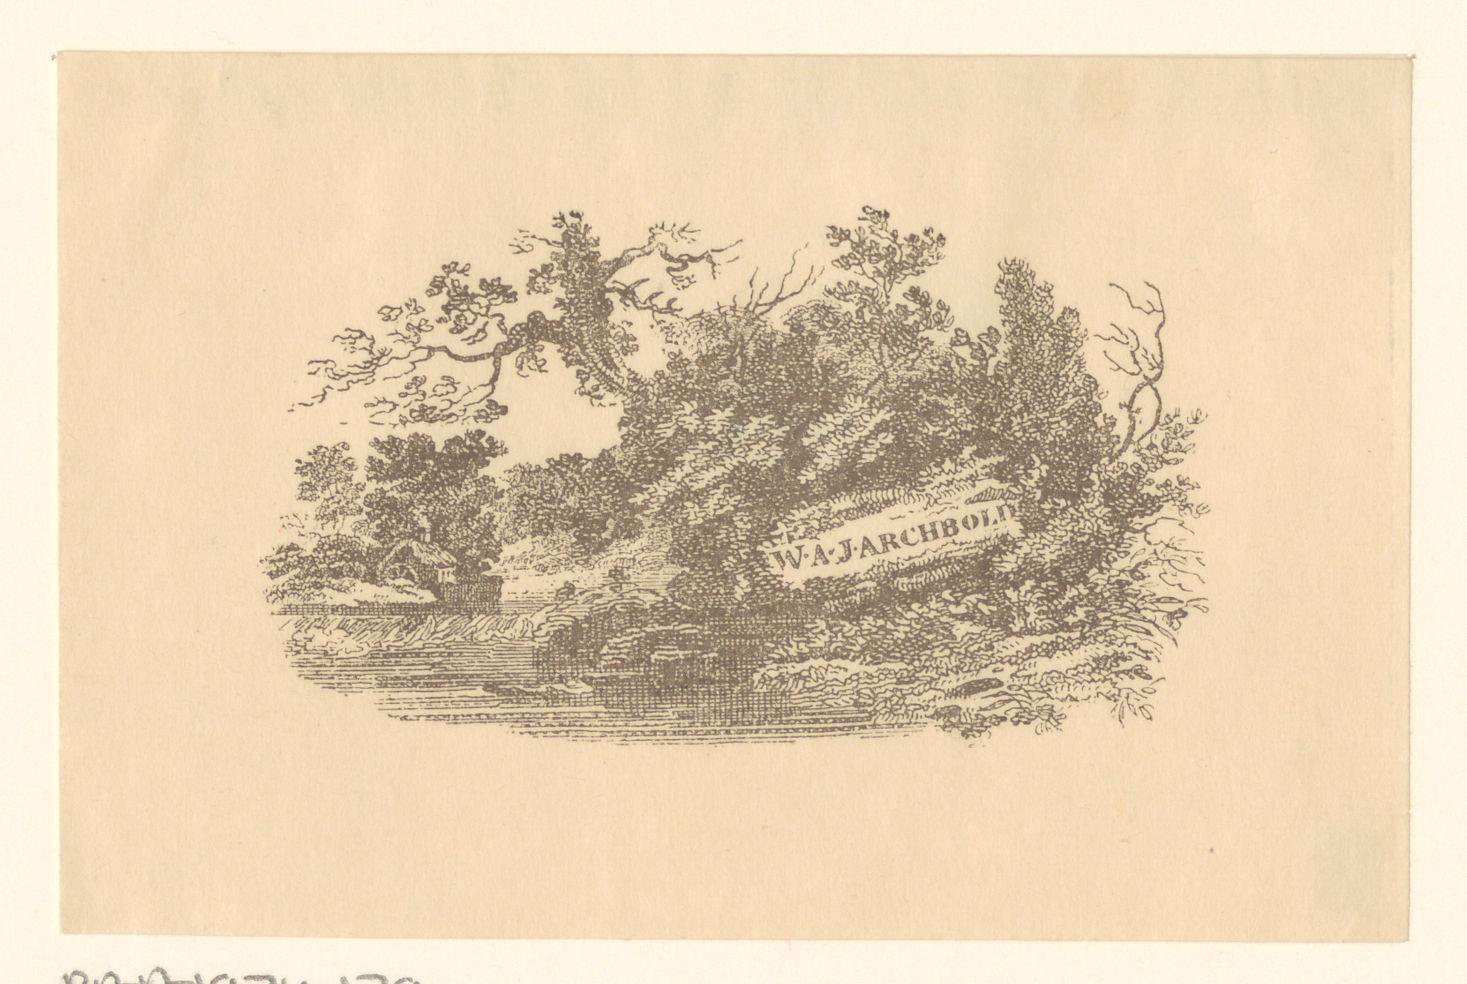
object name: bookplate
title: Ex libris van W.A.J. Archbold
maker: thomas bewick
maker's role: draughtsman, painter, print maker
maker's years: 1753-1828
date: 1768-1828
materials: paper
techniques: etching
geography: great britain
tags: shrubs